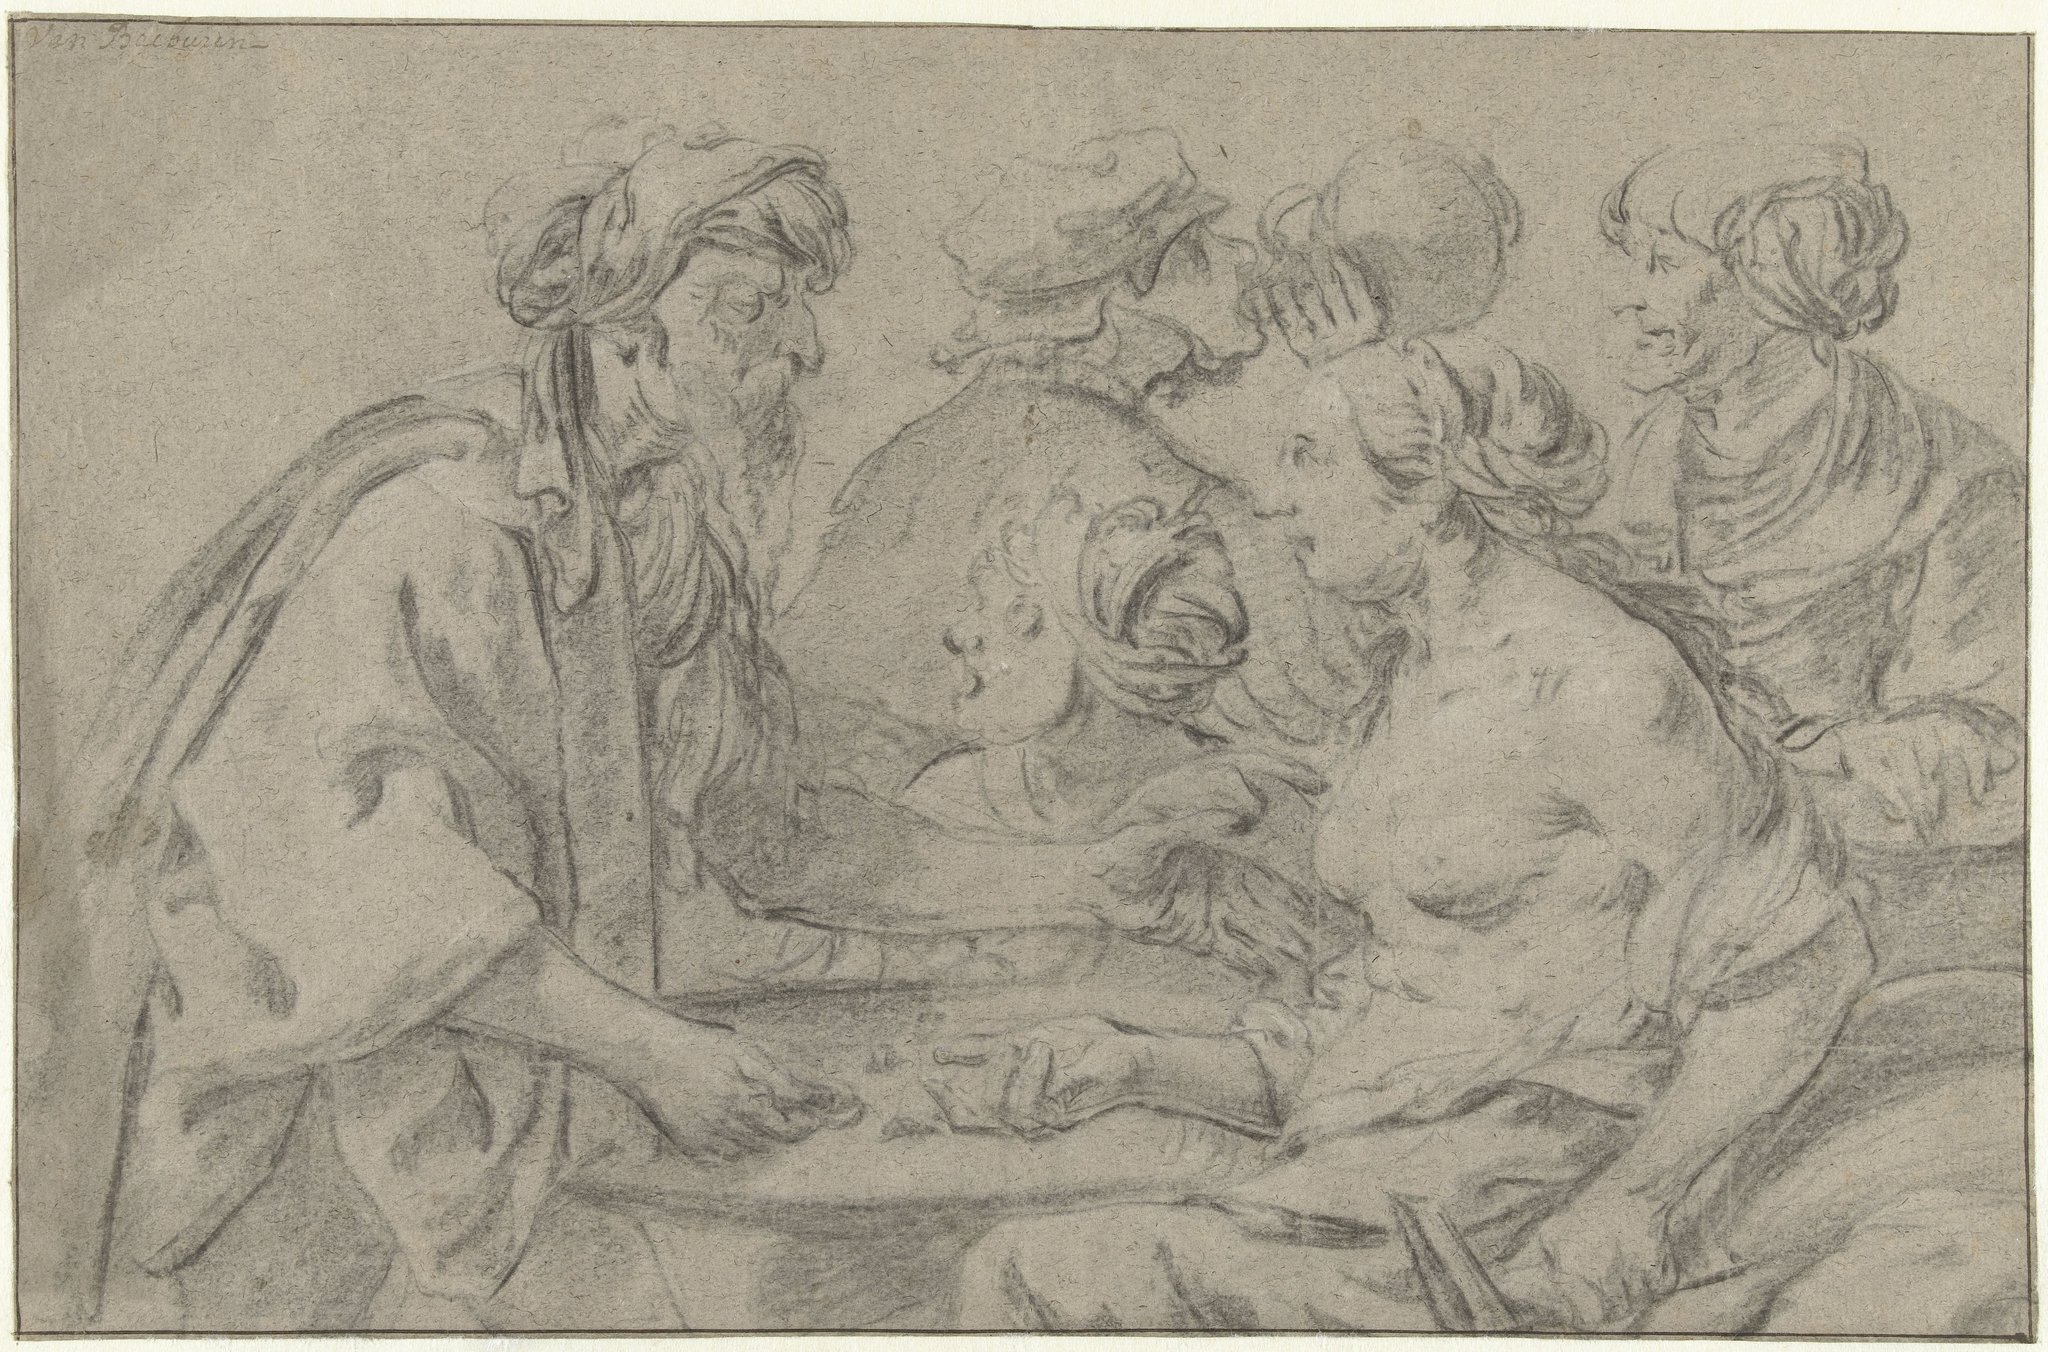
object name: drawing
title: Scene of mercenary love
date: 1600-1699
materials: chalk, paper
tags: carousal, drinking-bout, orgy, lute, and special forms of lute, e.g.: theorbo, drinking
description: Links staat een oude man in Oosterse kleding, rechts in profiel. Rechts zit een vrouw met ontblote borsten met een luit in de linkerhand, links in profiel, voor een tafel, waarop de man geld uittelt. Rechts op de achtergrond een oude vrouw en een man, die uit een kruik drinkt.